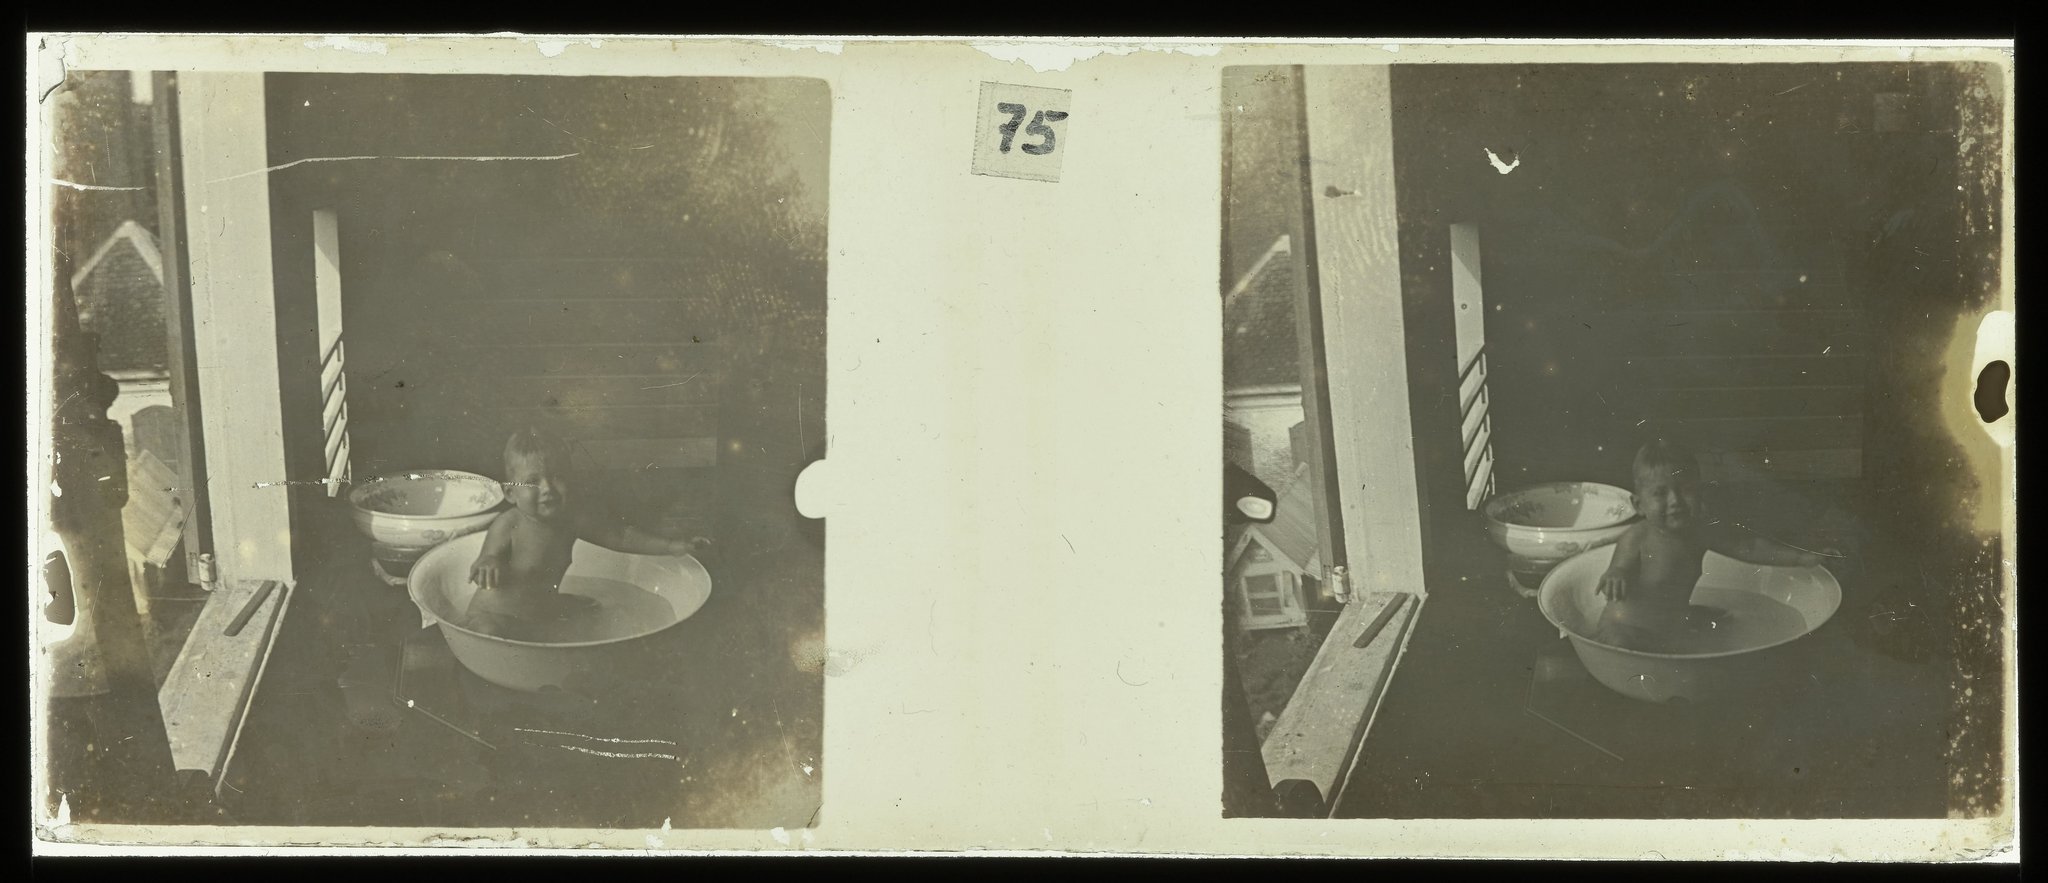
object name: stereograph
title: Plantage Accaribo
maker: theodoor brouwers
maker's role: amateurfotograaf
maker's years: 1874-1932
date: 1913-1930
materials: glass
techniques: photography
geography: suriname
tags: theodoor brouwers, plantation, suriname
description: In de periode 1911-1932 woonde op plantage Accaribo in Suriname de familie Brouwers van wie de foto's afkomstig zijn. Rond 1910 vond Theodoor Brouwers werk op plantage Accaribo. In 1929 werd hij eigenaar van de plantage. Op Accaribo werden in zijn tijd bananen geproduceerd en wat koffie.